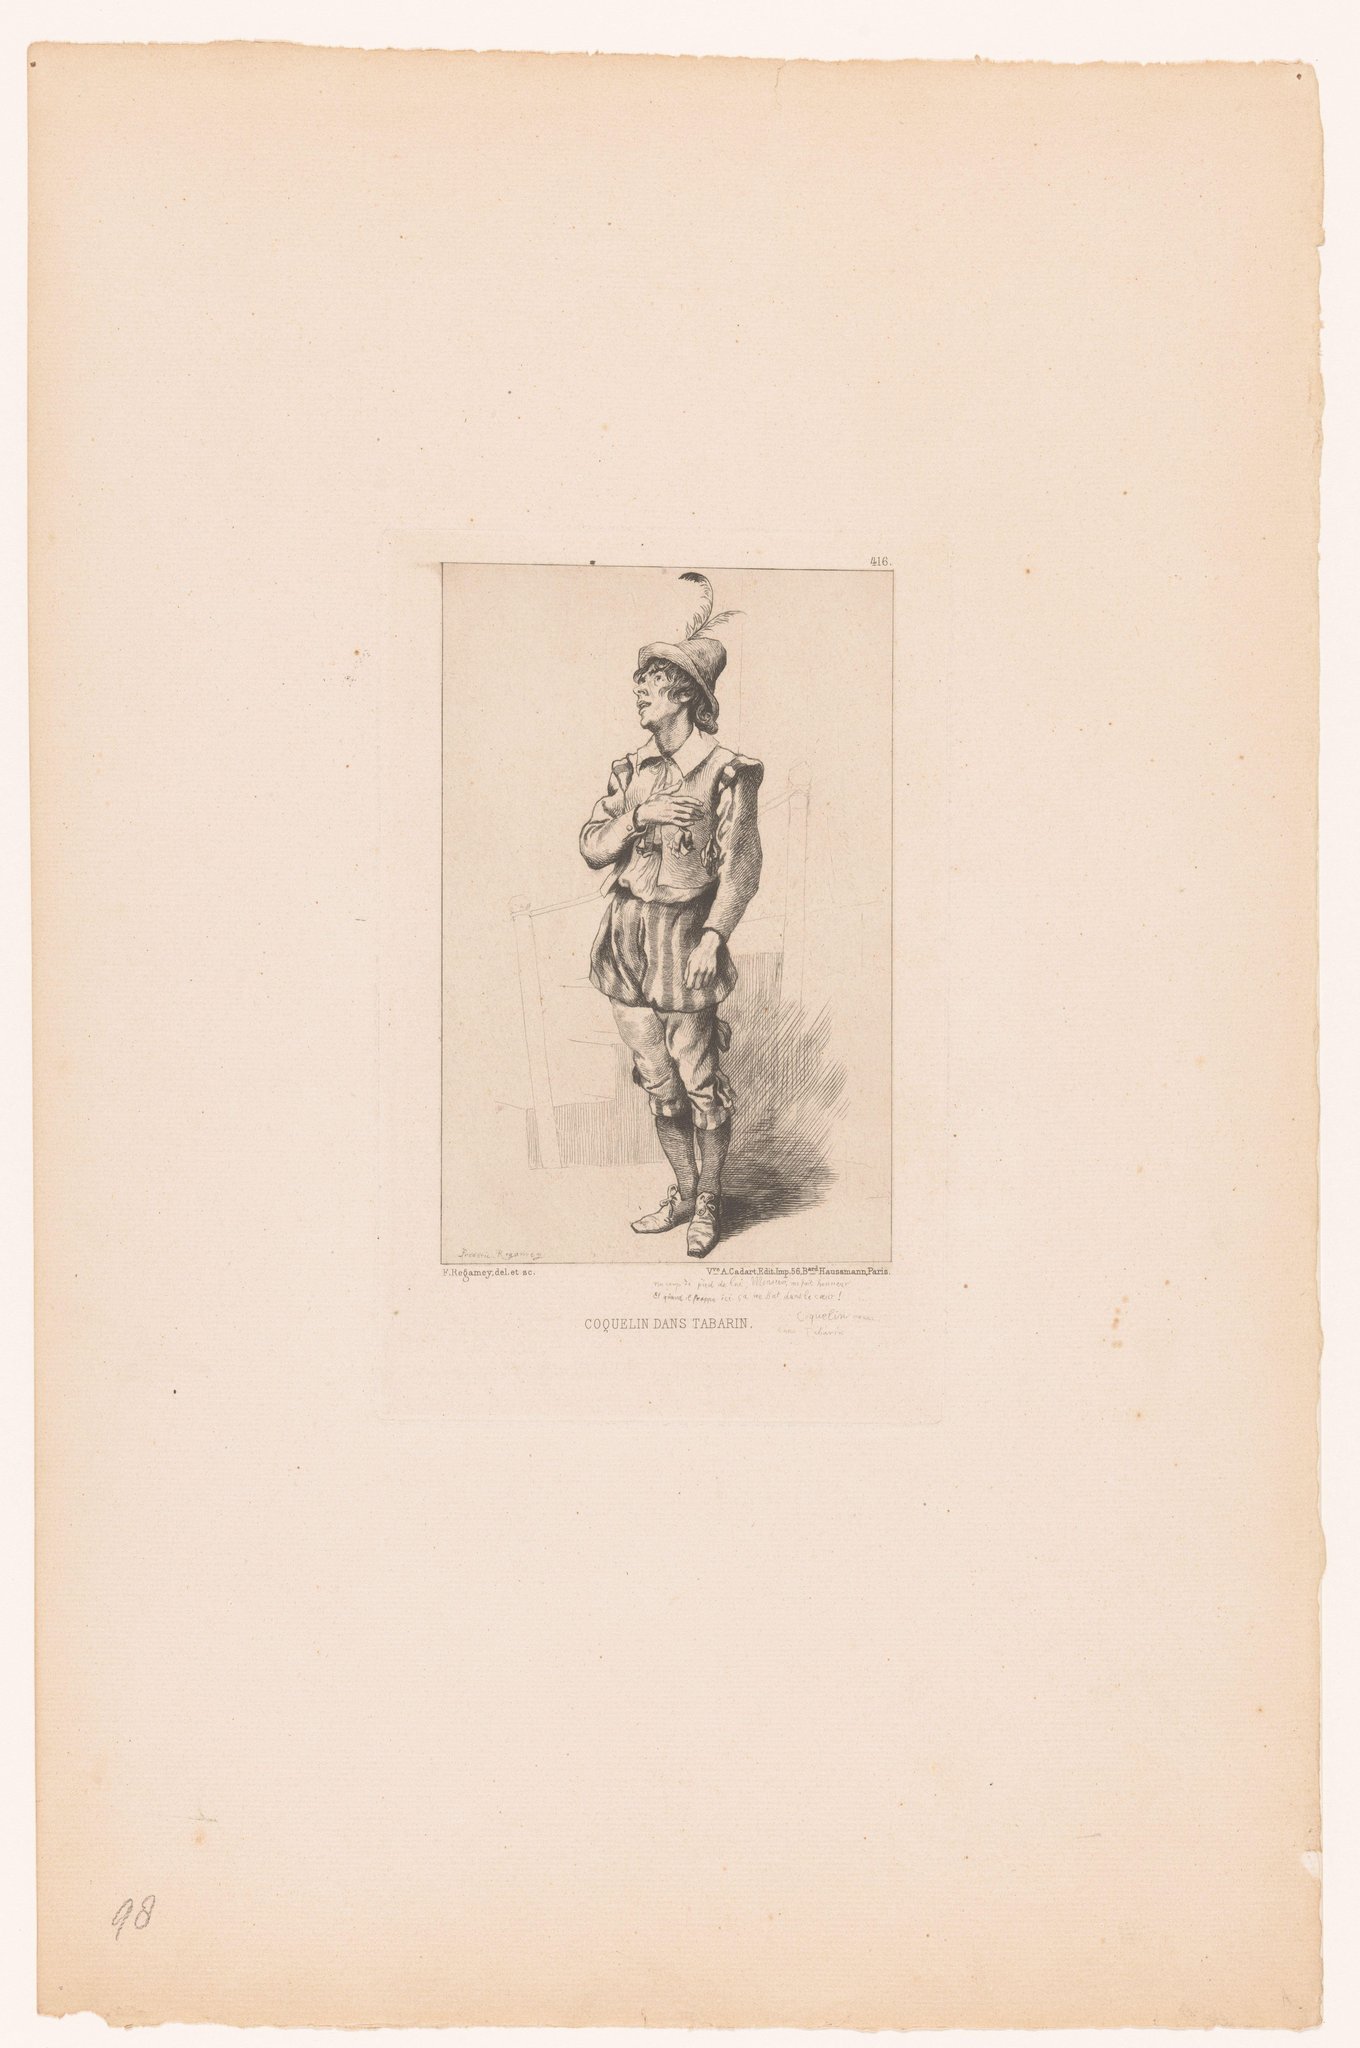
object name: print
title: Coquelin dans Tabarin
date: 1875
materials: paper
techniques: etching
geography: paris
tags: actor (on the stage)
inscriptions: collector's mark: Lugt 2233